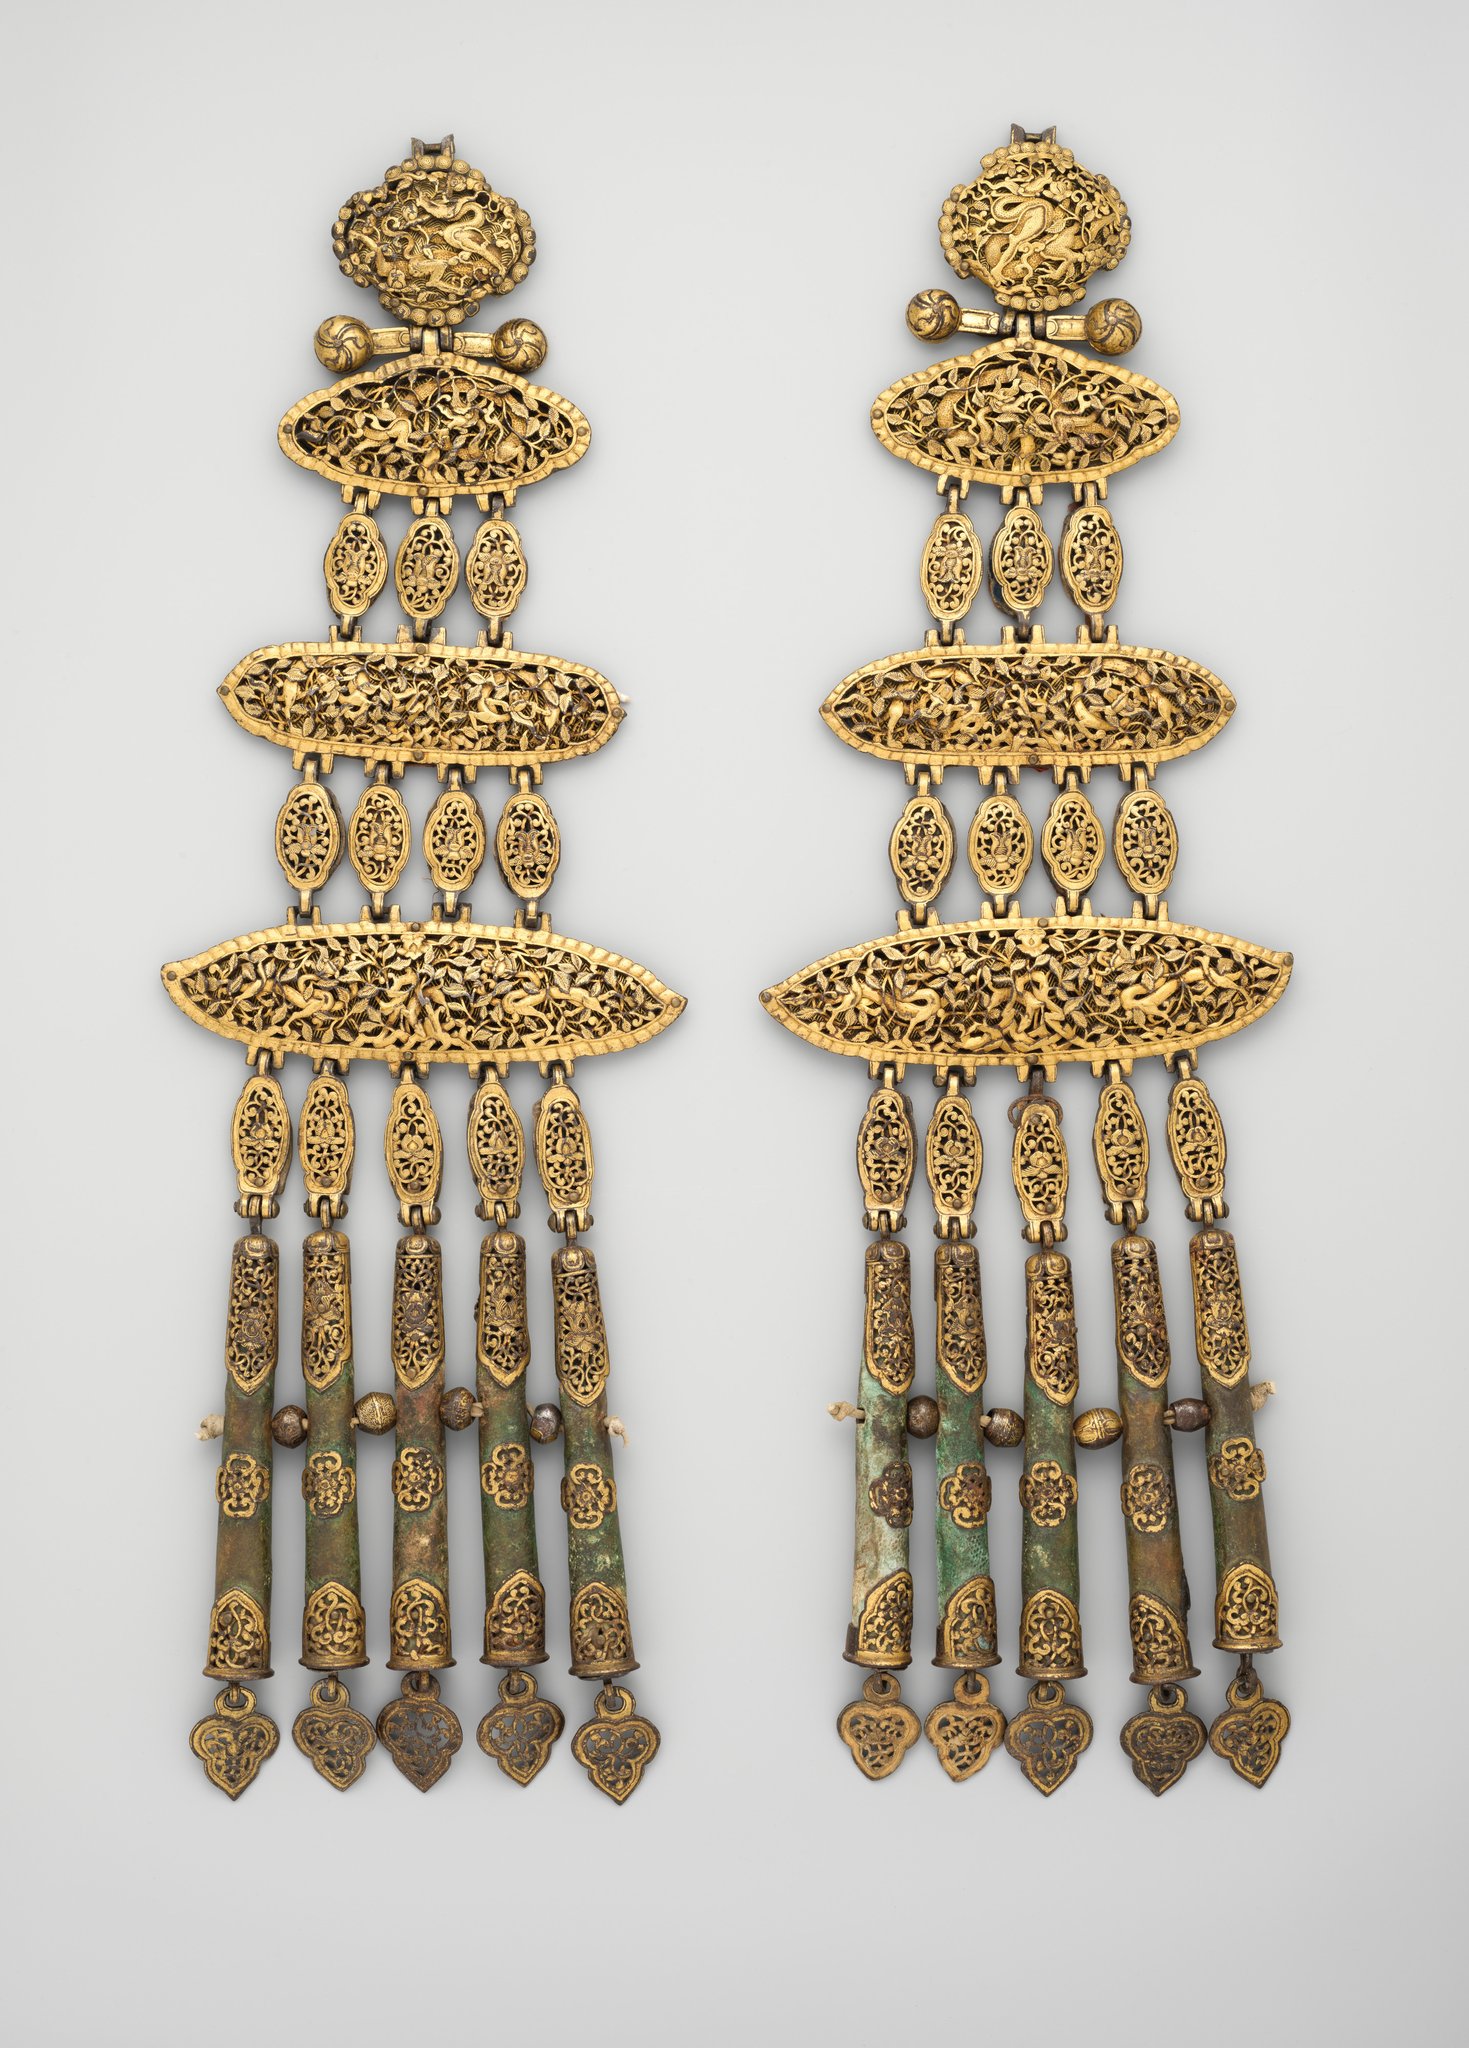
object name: pair of crupper pendant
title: Pair of Crupper Pendants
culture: tibetan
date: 1301-1500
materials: copper alloy, gold, iron, leather, wood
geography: tibet